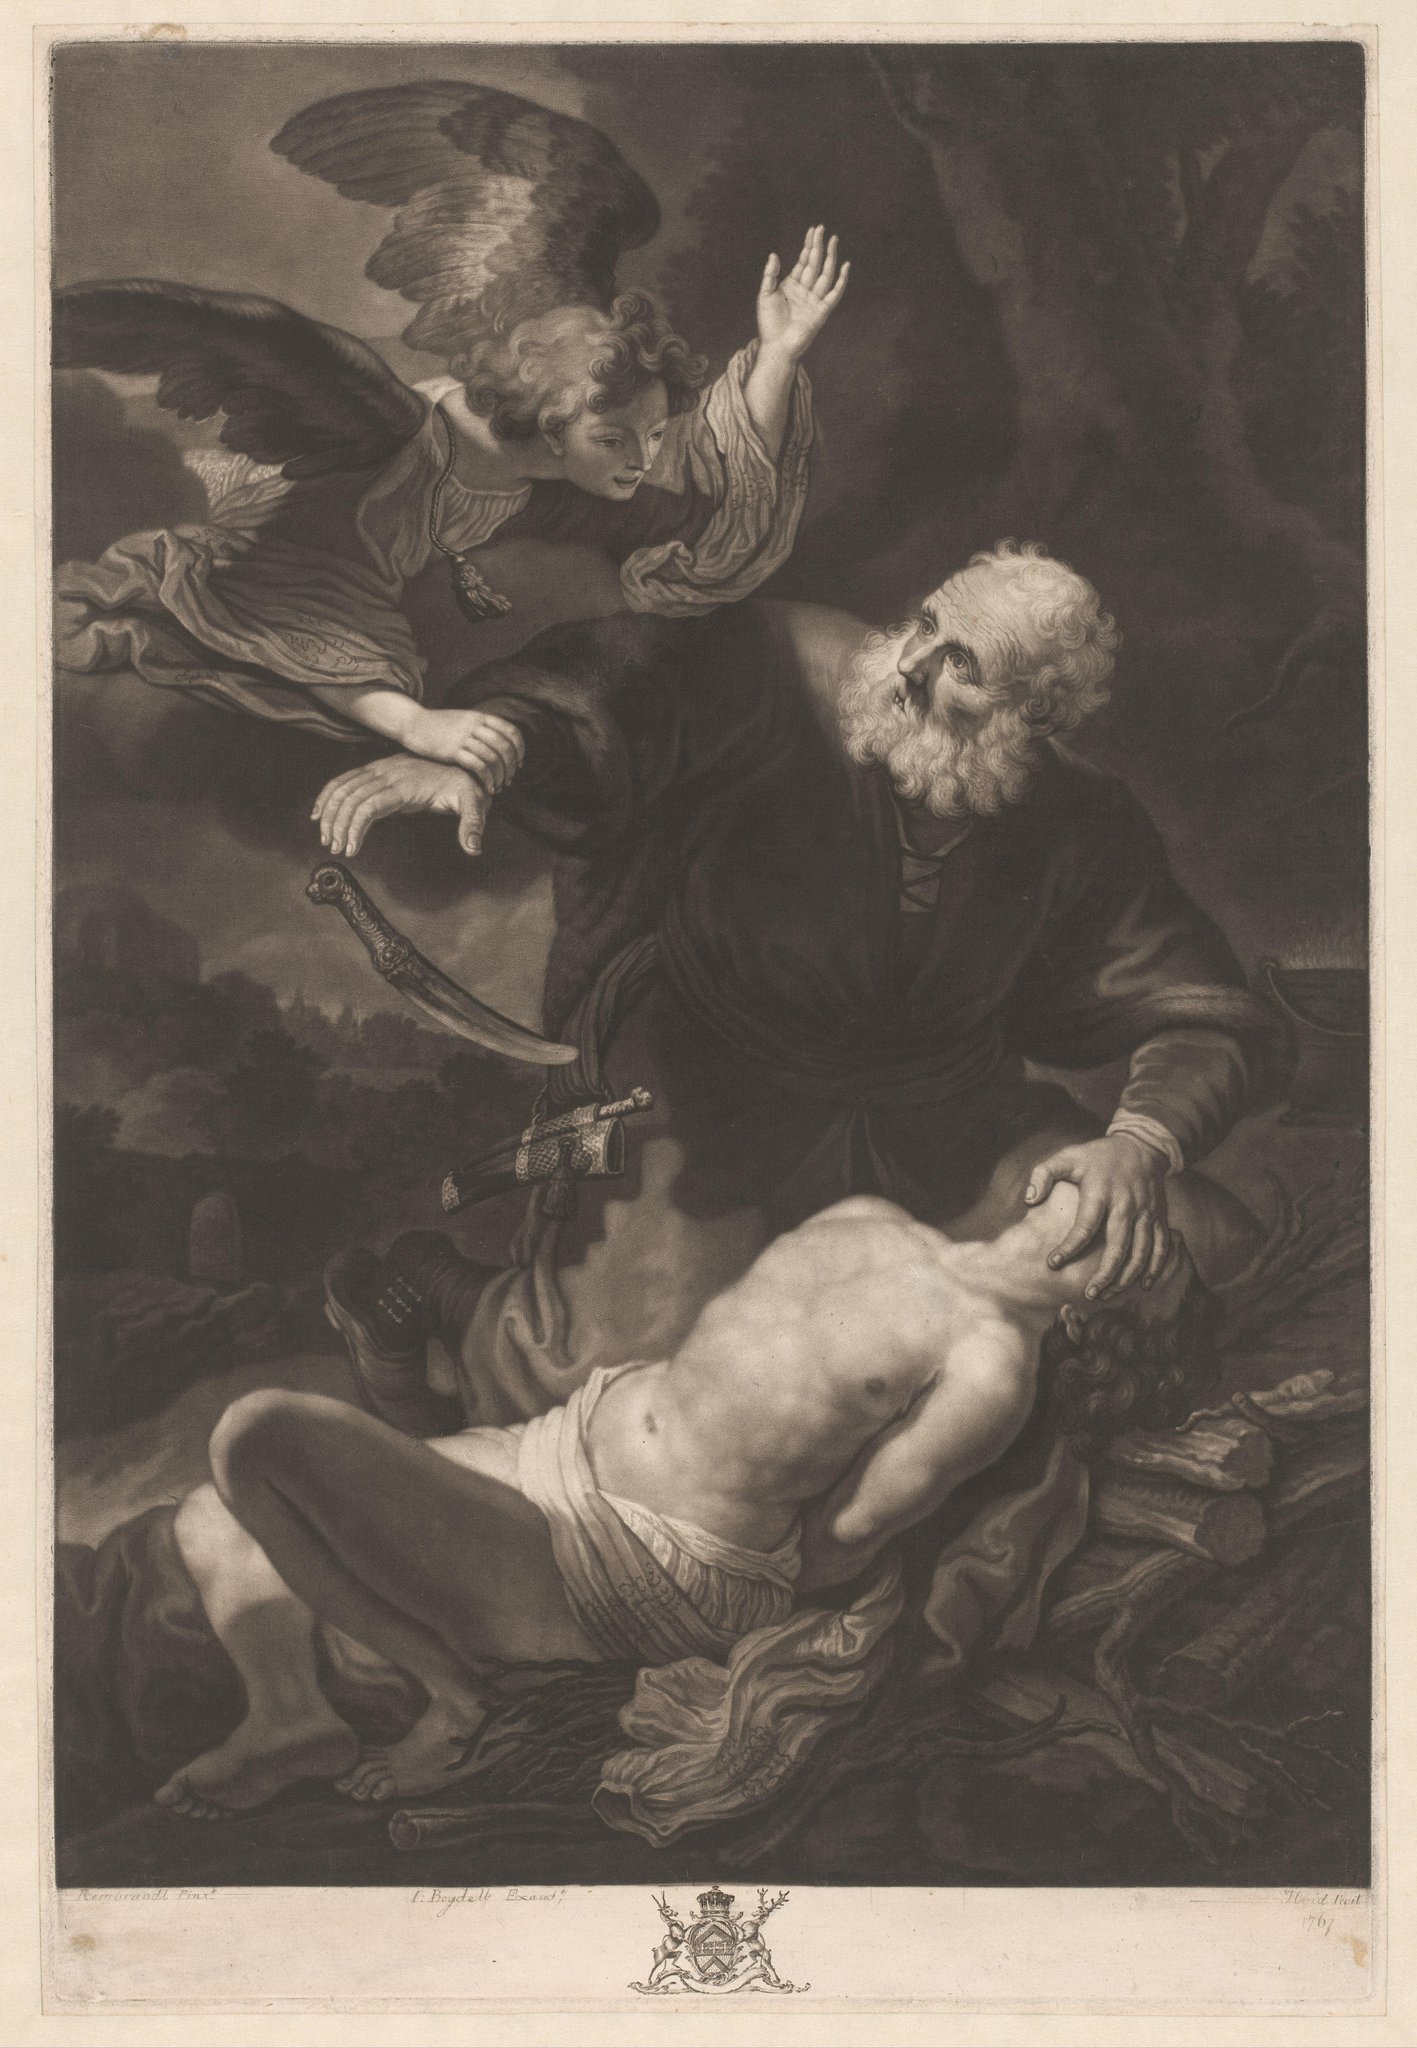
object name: print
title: Offer van Abraham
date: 1767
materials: paper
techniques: mezzotint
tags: when abraham has his hand raised to kill isaac, an angel restrains abraham's hand, armorial bearing, heraldry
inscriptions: collector's mark: Lugt 2760, collector's mark: Lugt 2228